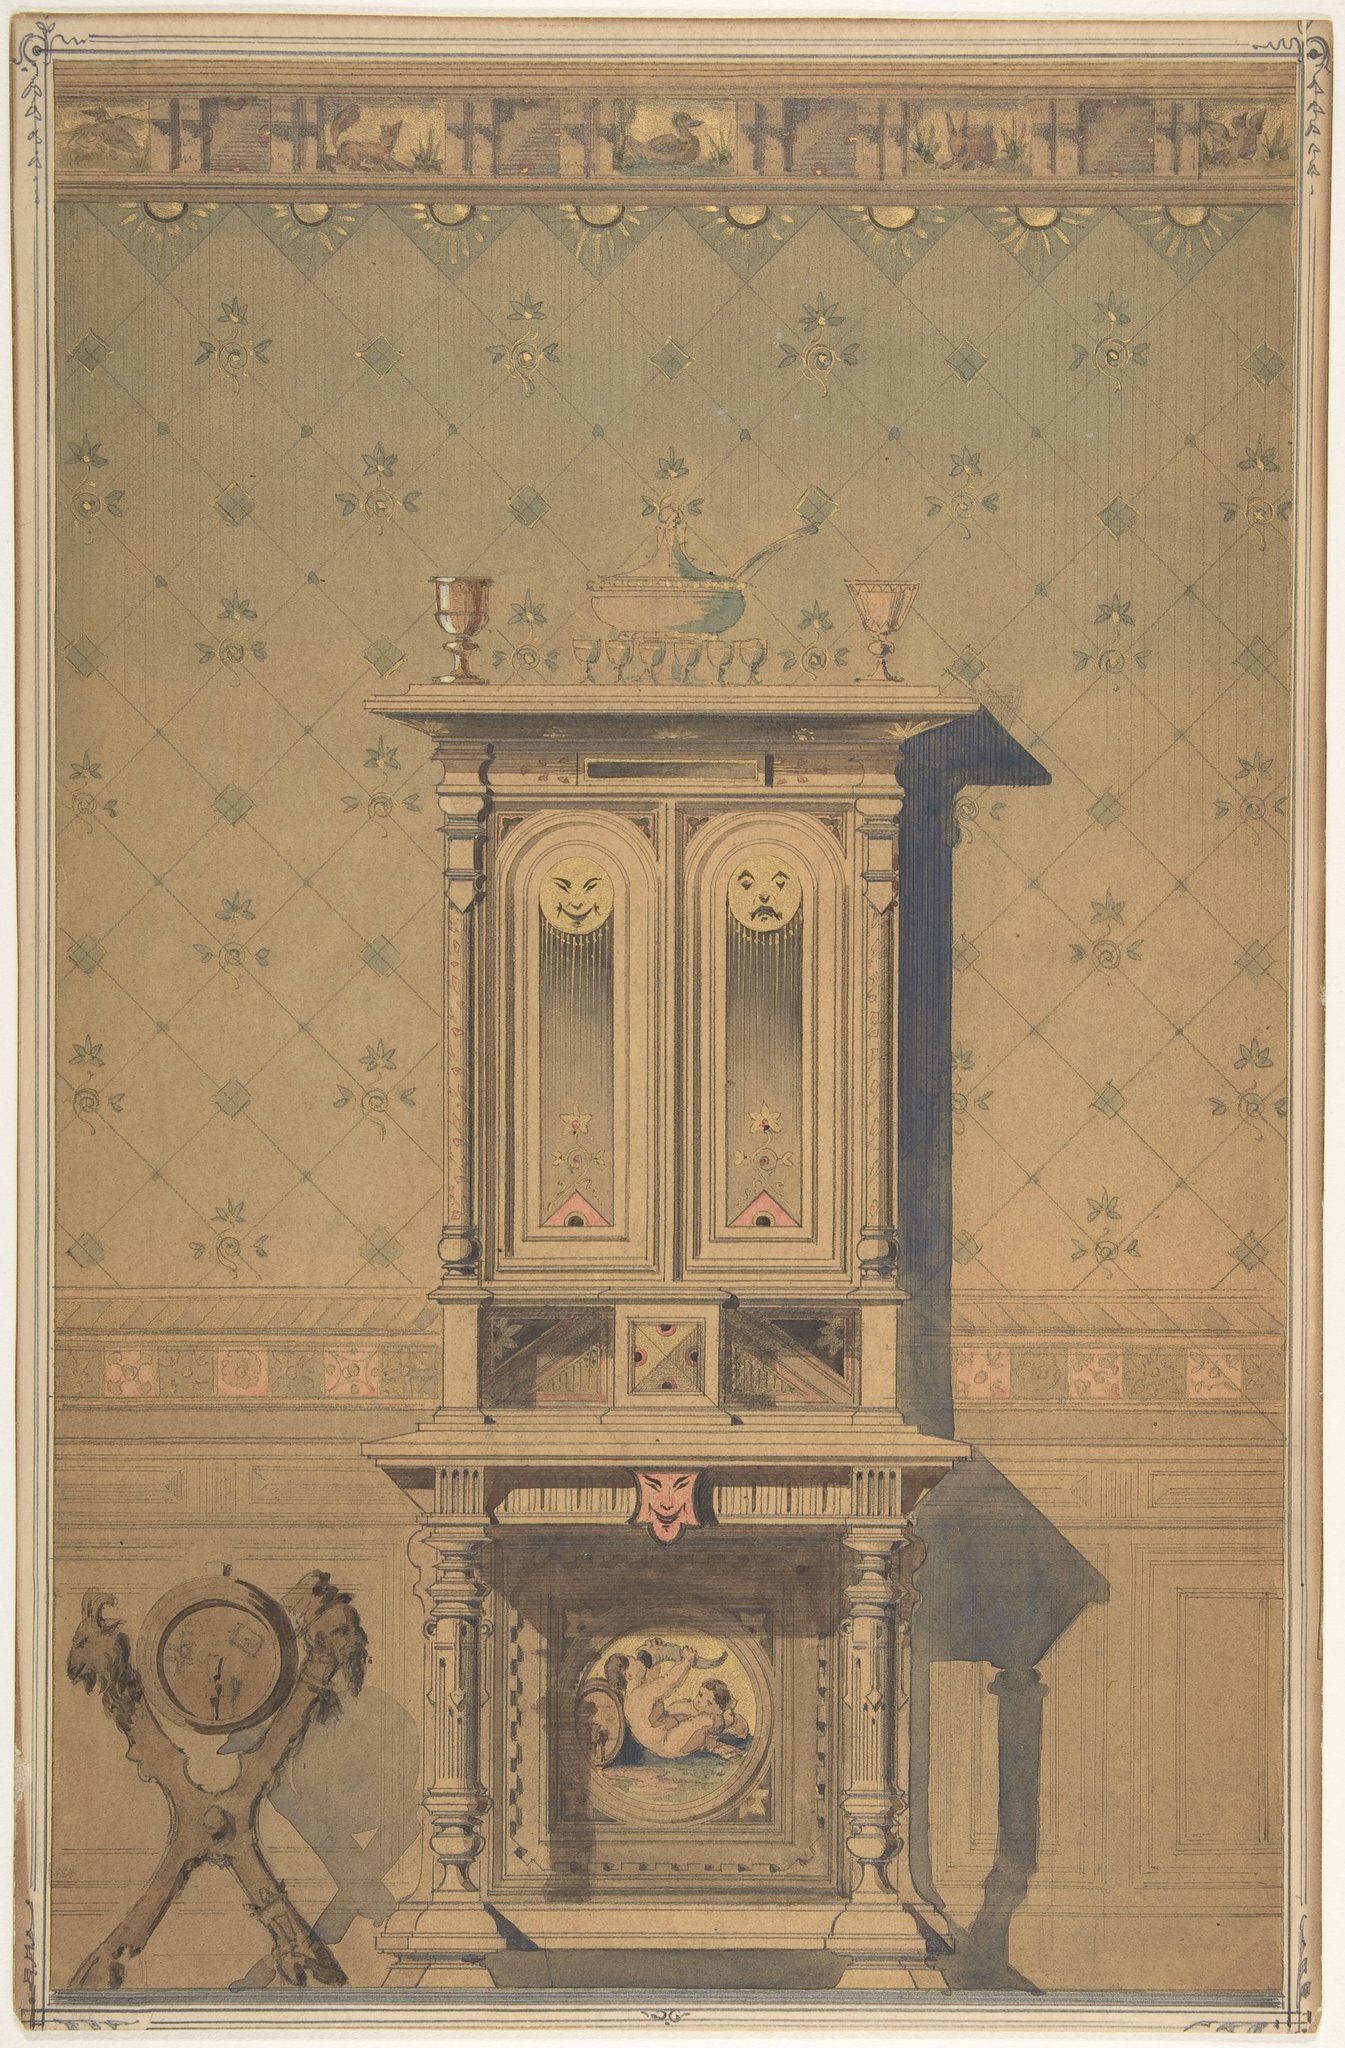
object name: drawing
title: Design for a Cabinet in an Interior Setting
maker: anonymous, german, 19th century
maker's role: artist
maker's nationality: german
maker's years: 1800-1899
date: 1870-1880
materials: cardboard, graphite, paint, pencil, paper, watercolor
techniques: wash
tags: faces,female nudes,cabinets